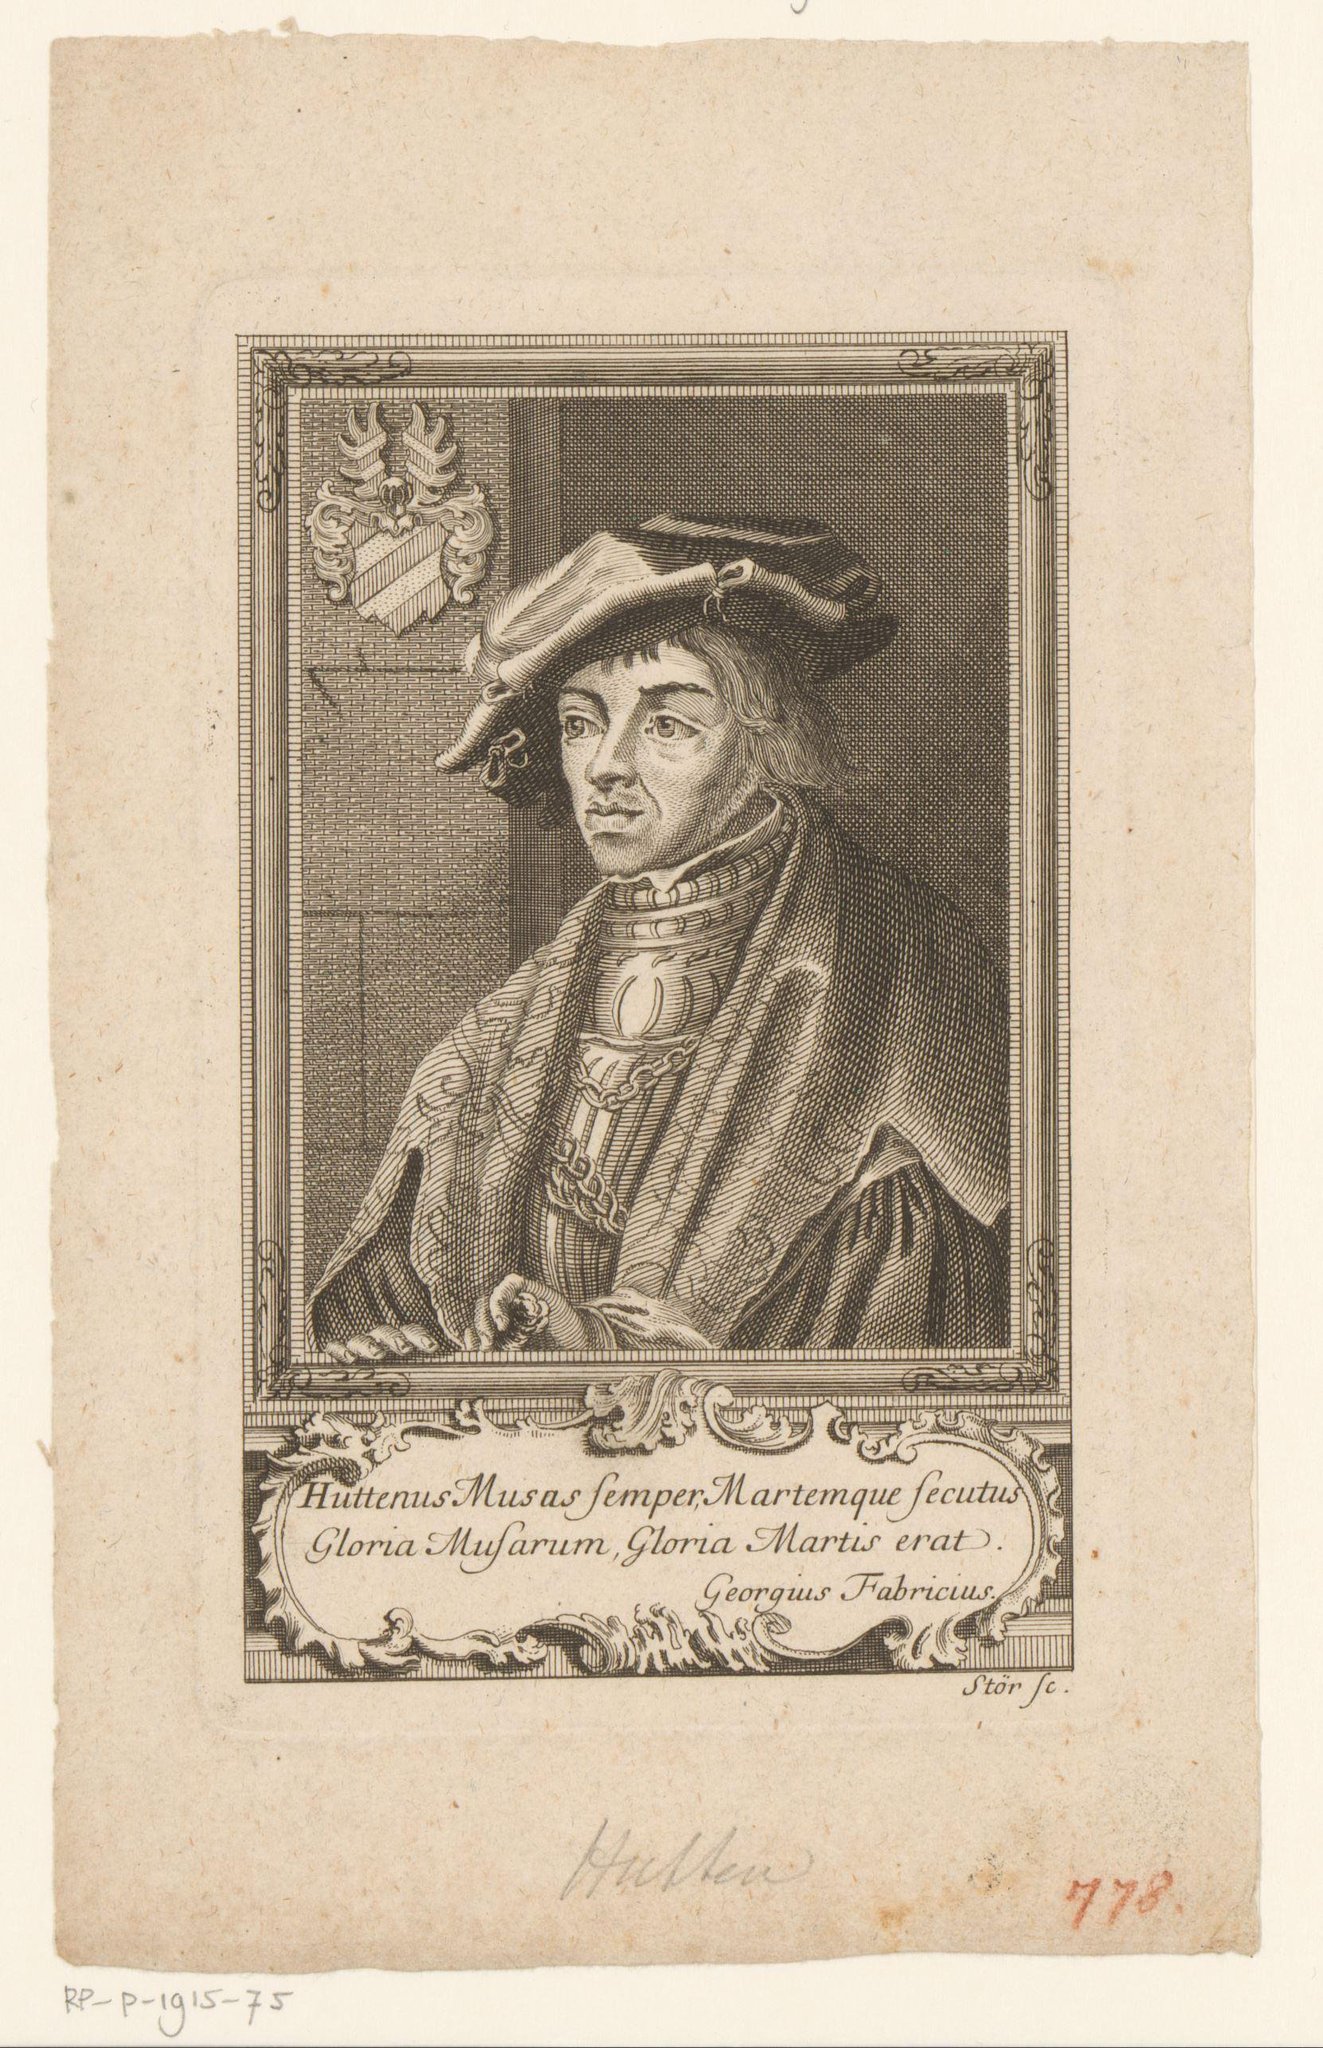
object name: print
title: Portret van Ulrich von Hutten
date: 1715-1765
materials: paper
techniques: engraving, etching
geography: nuremberg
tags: switzerland, politician, historical persons, armorial bearing, heraldry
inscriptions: collector's mark: Lugt 2228, number: ‘778’